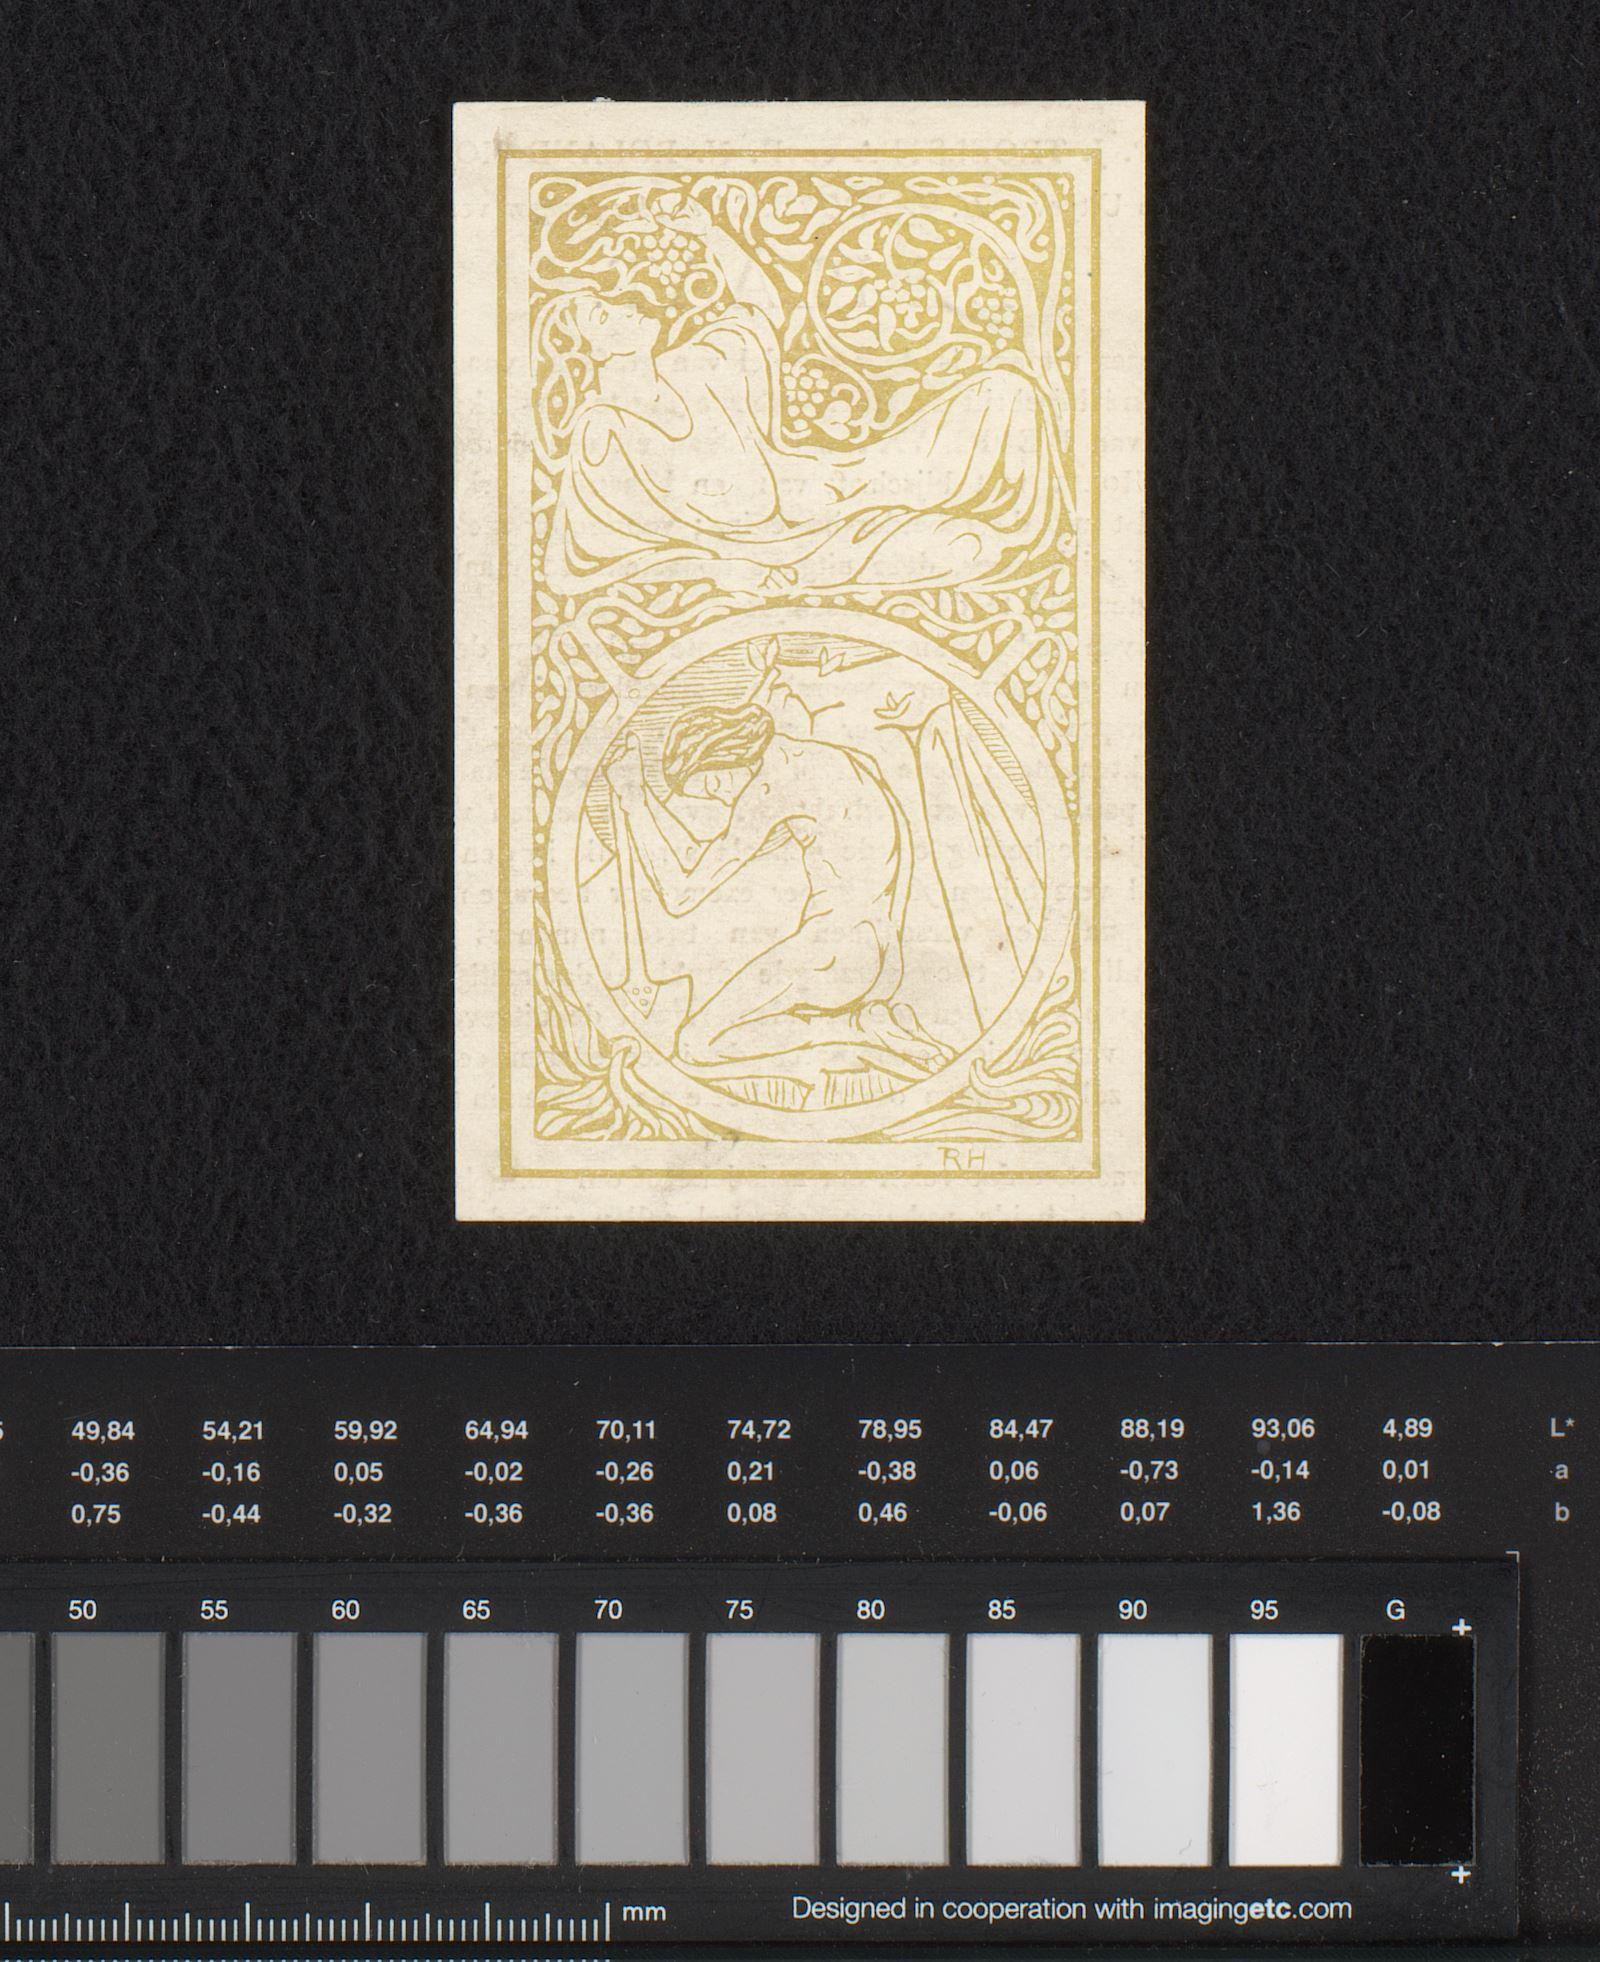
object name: photomechanical print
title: Vignet voor de aankondiging van tijdschrift 'De Plaat' door uitgever H.J. Poutsma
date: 1898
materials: paper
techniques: letterpress printing, printing block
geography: amsterdam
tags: agricultural implements: spade, bunch of grapes, kneeling on both knees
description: Deel van de aankondigingstekst op het verso.